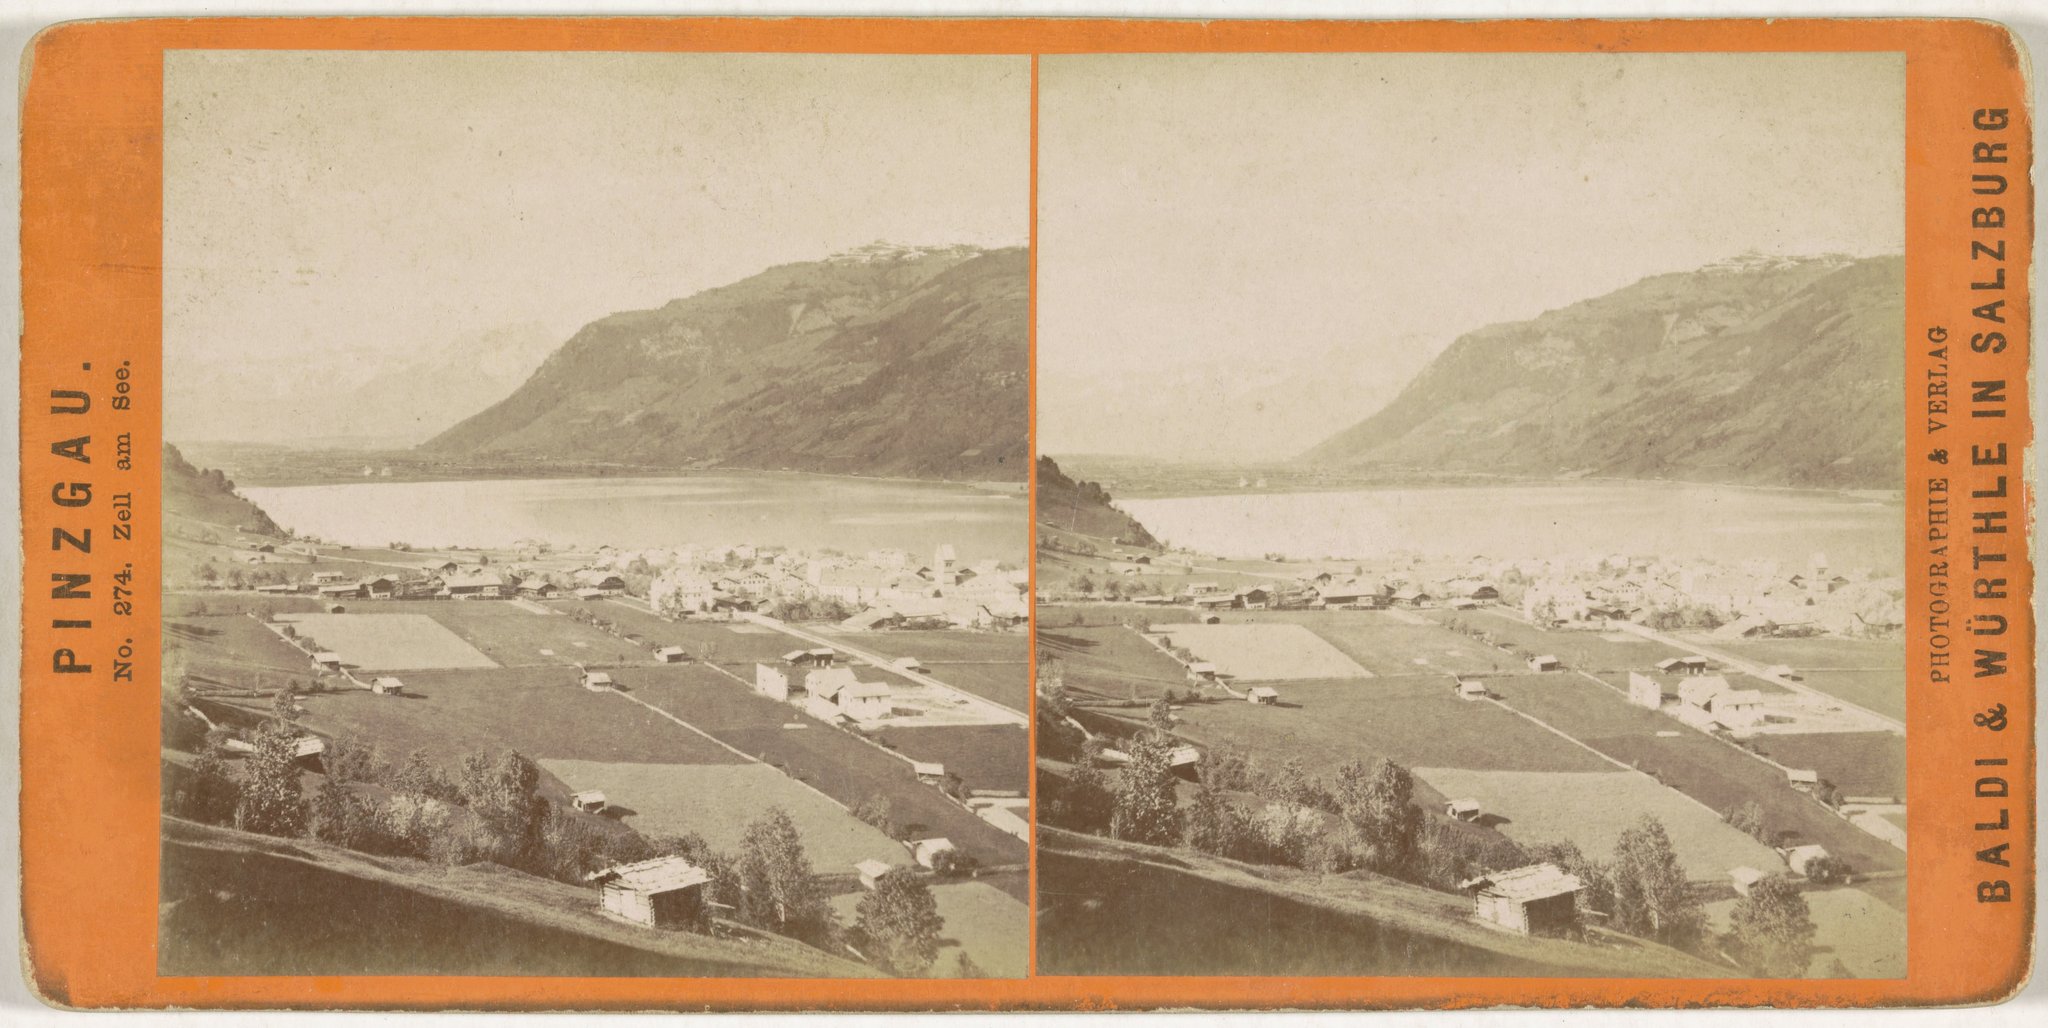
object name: stereograph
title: Zell am See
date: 1862-1880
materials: cardboard, paper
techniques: albumen print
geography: zell am see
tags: prospect of village, silhouette of village, mountains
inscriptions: number: ‘No. 274’